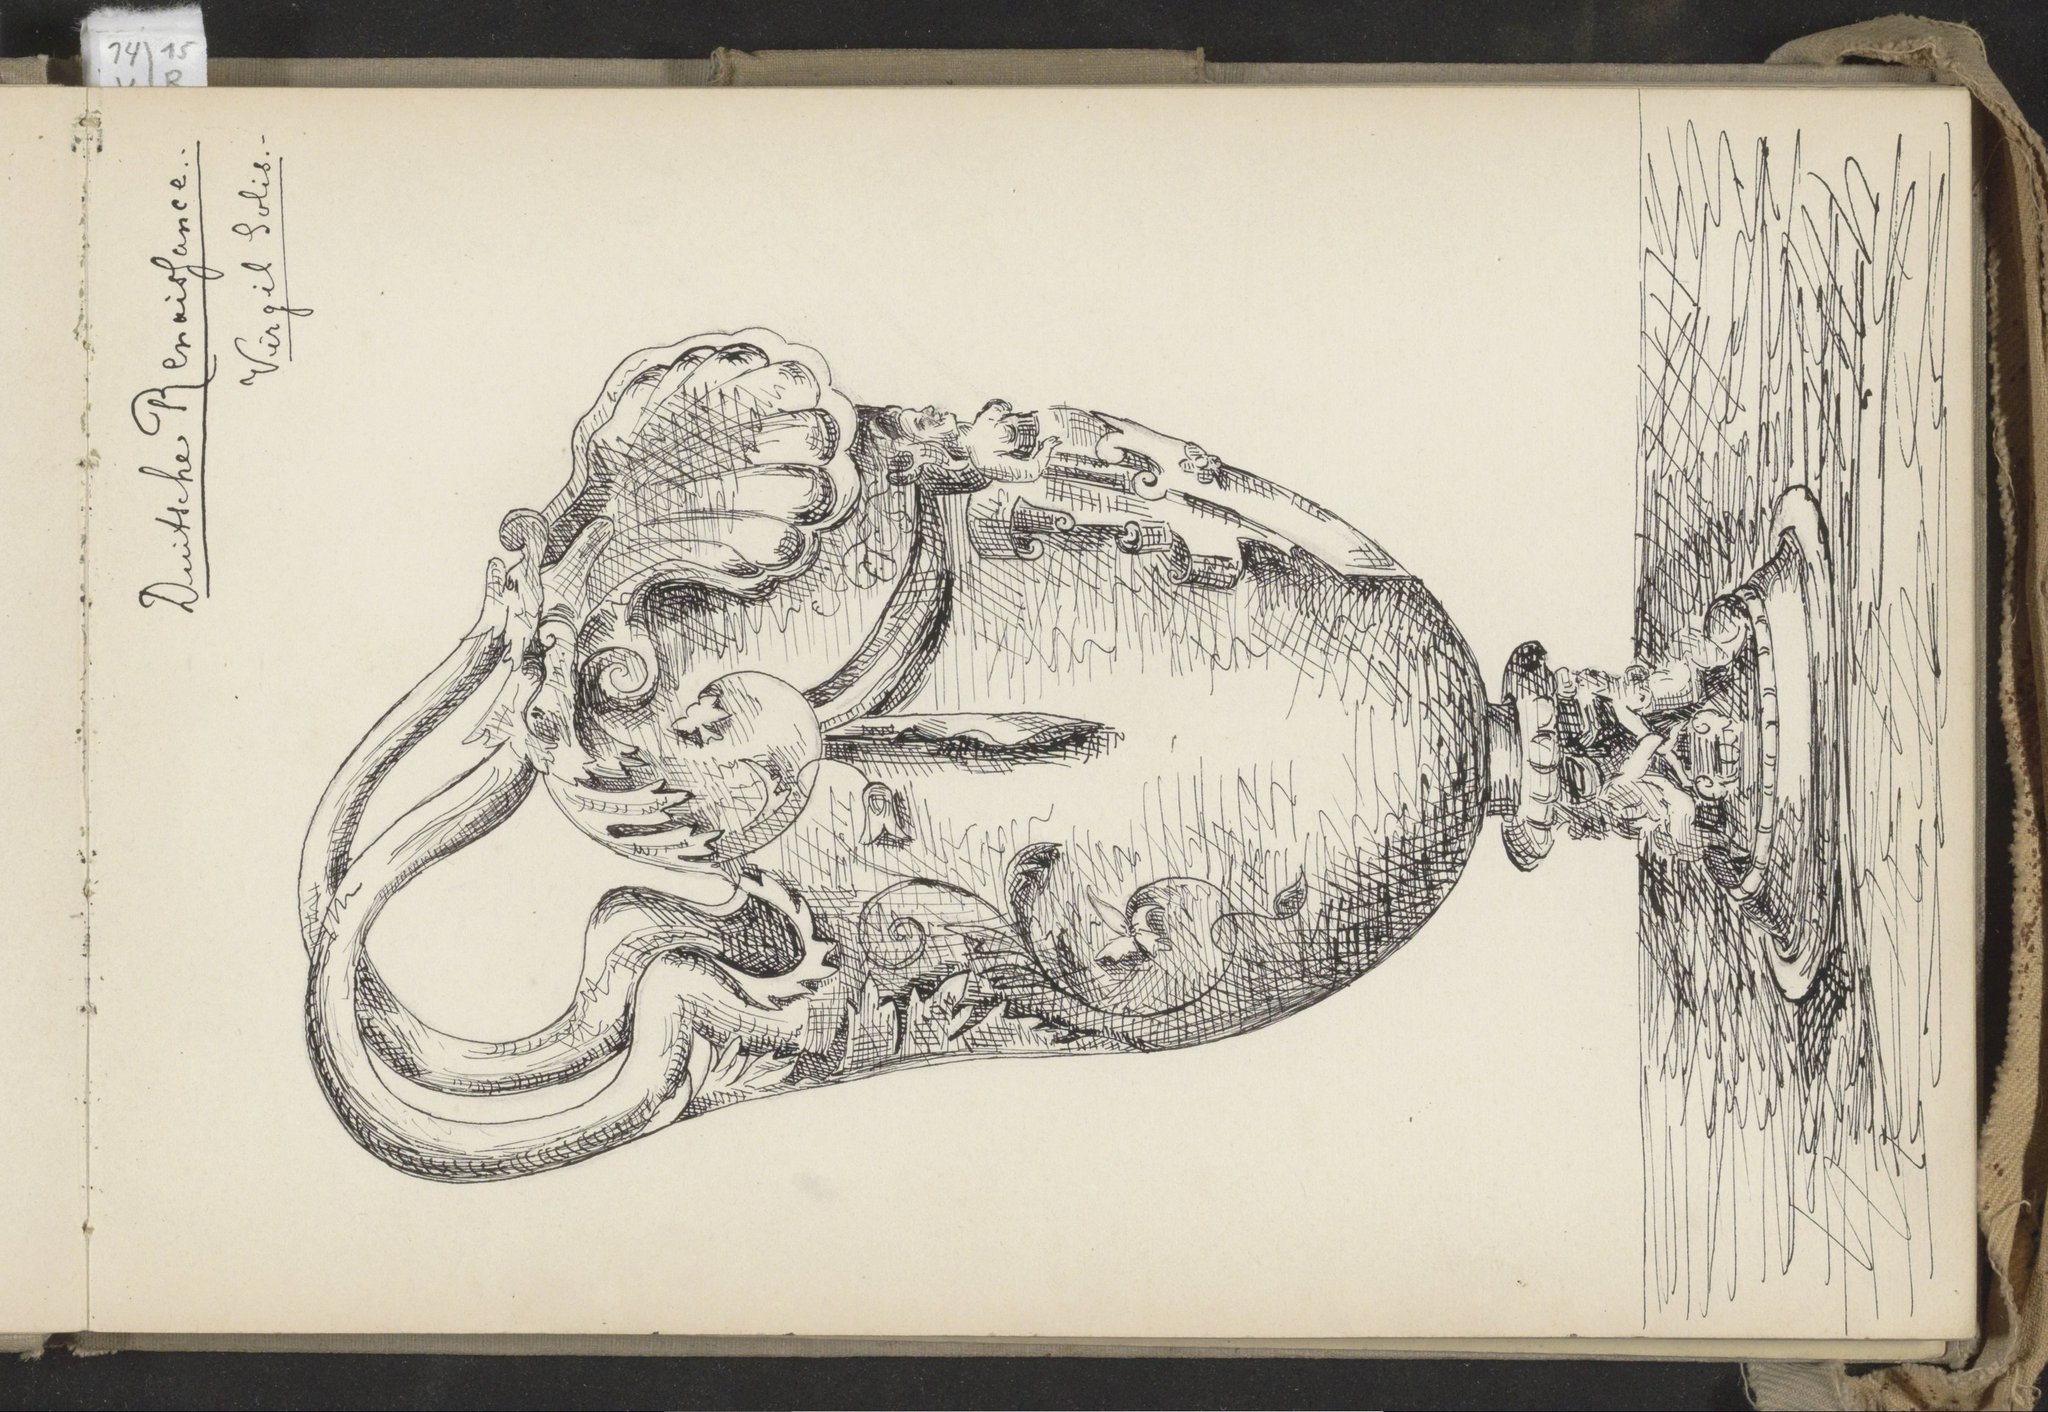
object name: sketchbook leaf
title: Kelk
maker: johanna van de kamer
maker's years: 1873-1922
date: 1890-1922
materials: ink, paper, pencil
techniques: pen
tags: chalice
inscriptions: annotation: ‘Duitsche Renaissance./ Virgil Solis’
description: Blad 11 recto uit een schetsboek met 49 bladen.